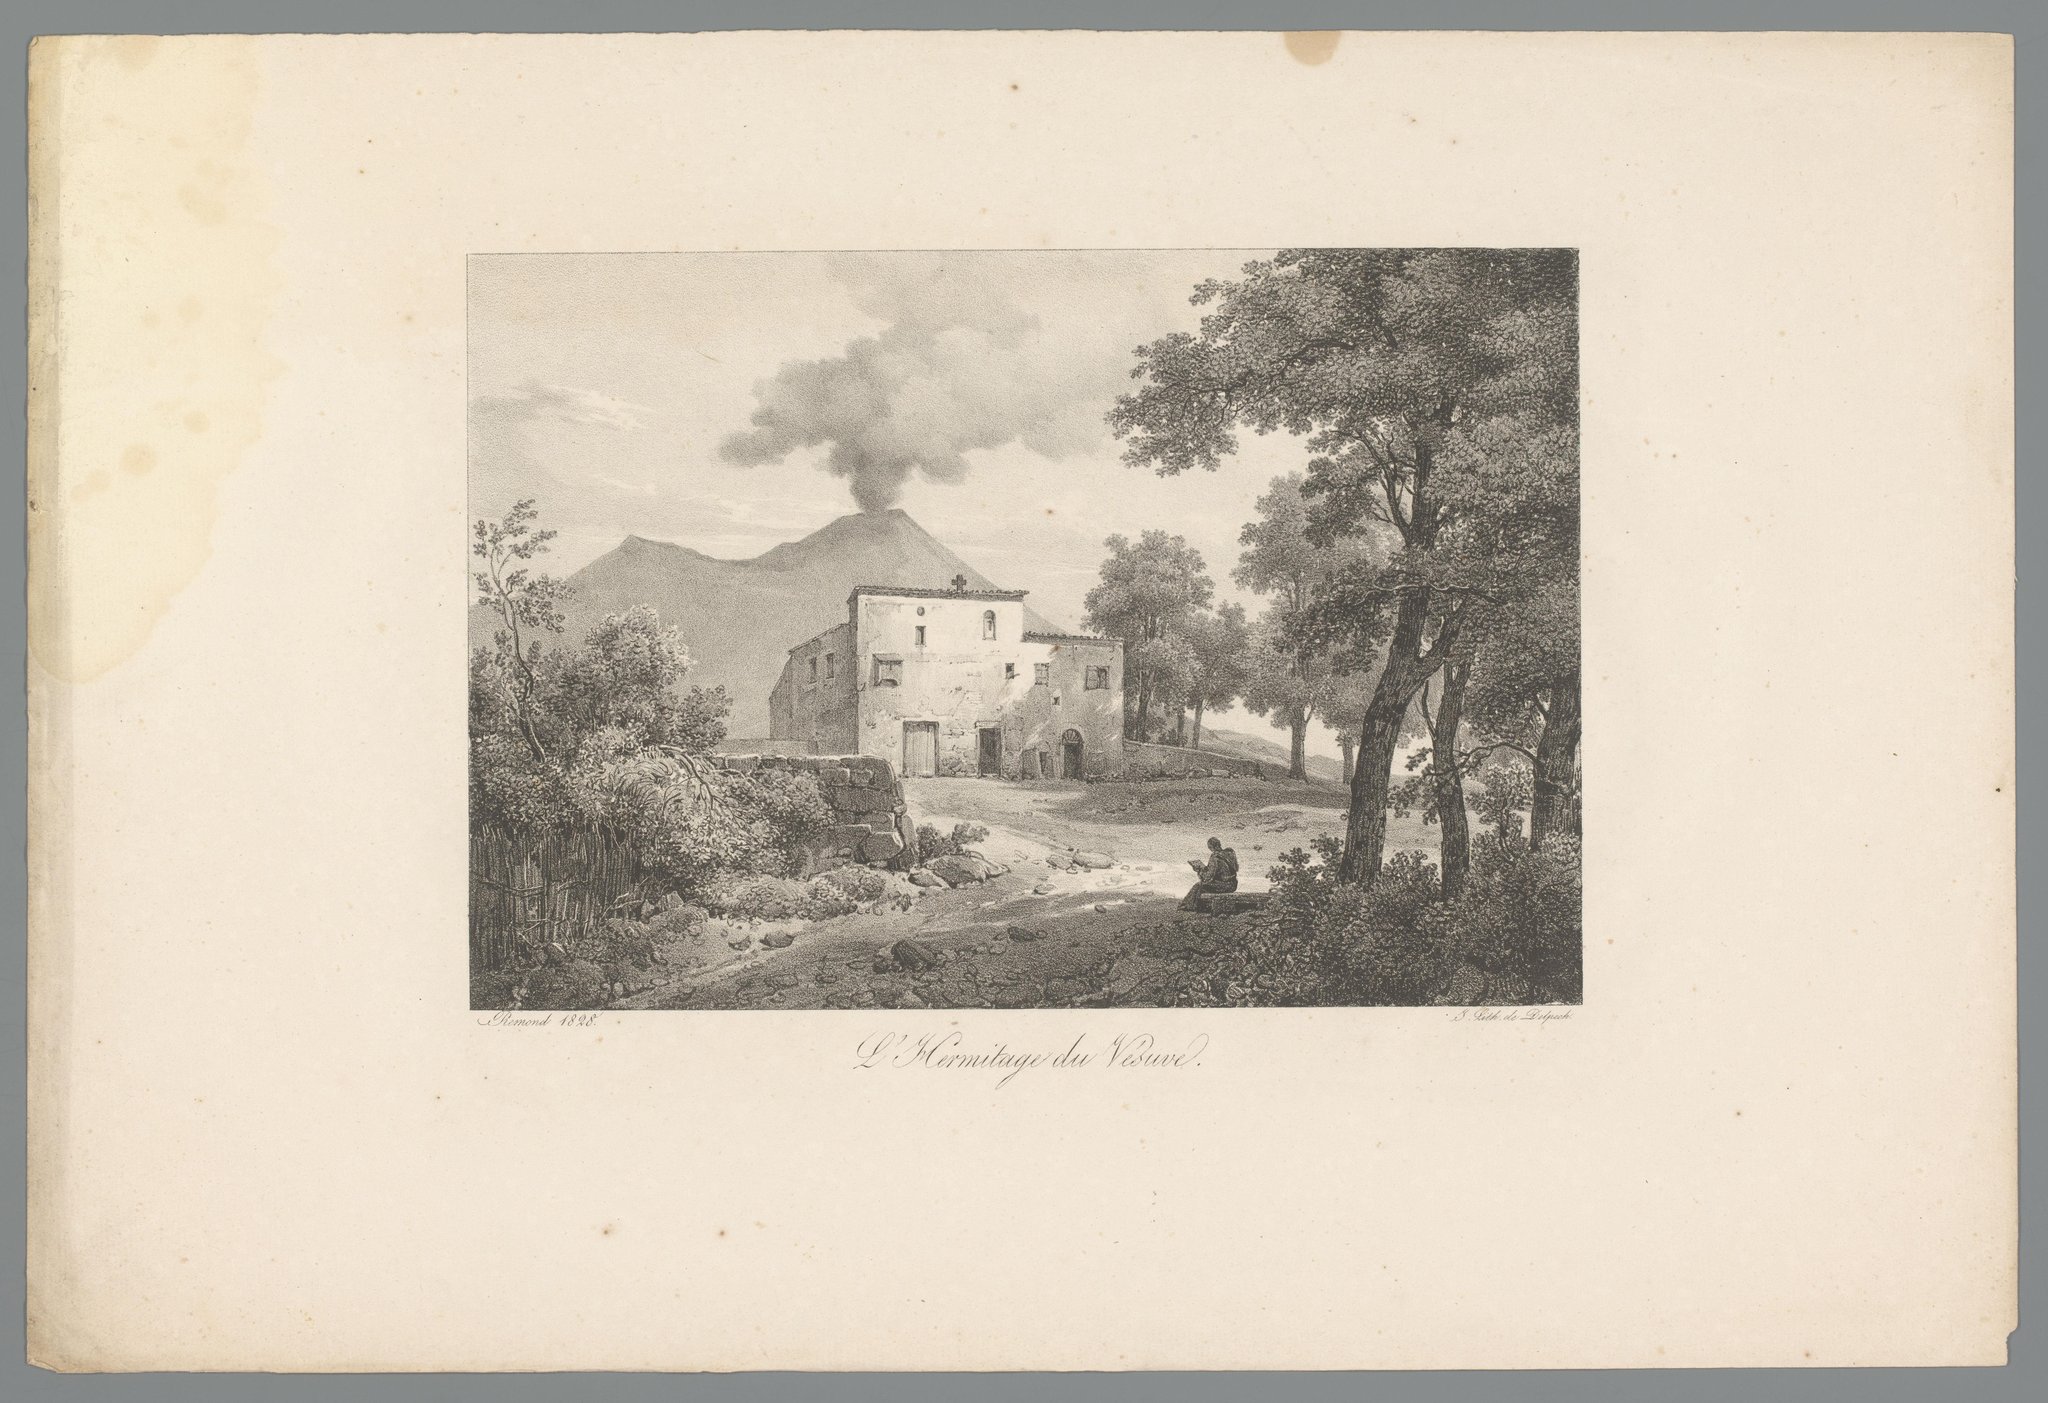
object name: print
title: Vues d'Italie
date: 1828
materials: paper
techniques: lithograph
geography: paris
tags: landscapes, anchorite, hermit, mount vesuvius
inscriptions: collector's mark: Lugt 2228